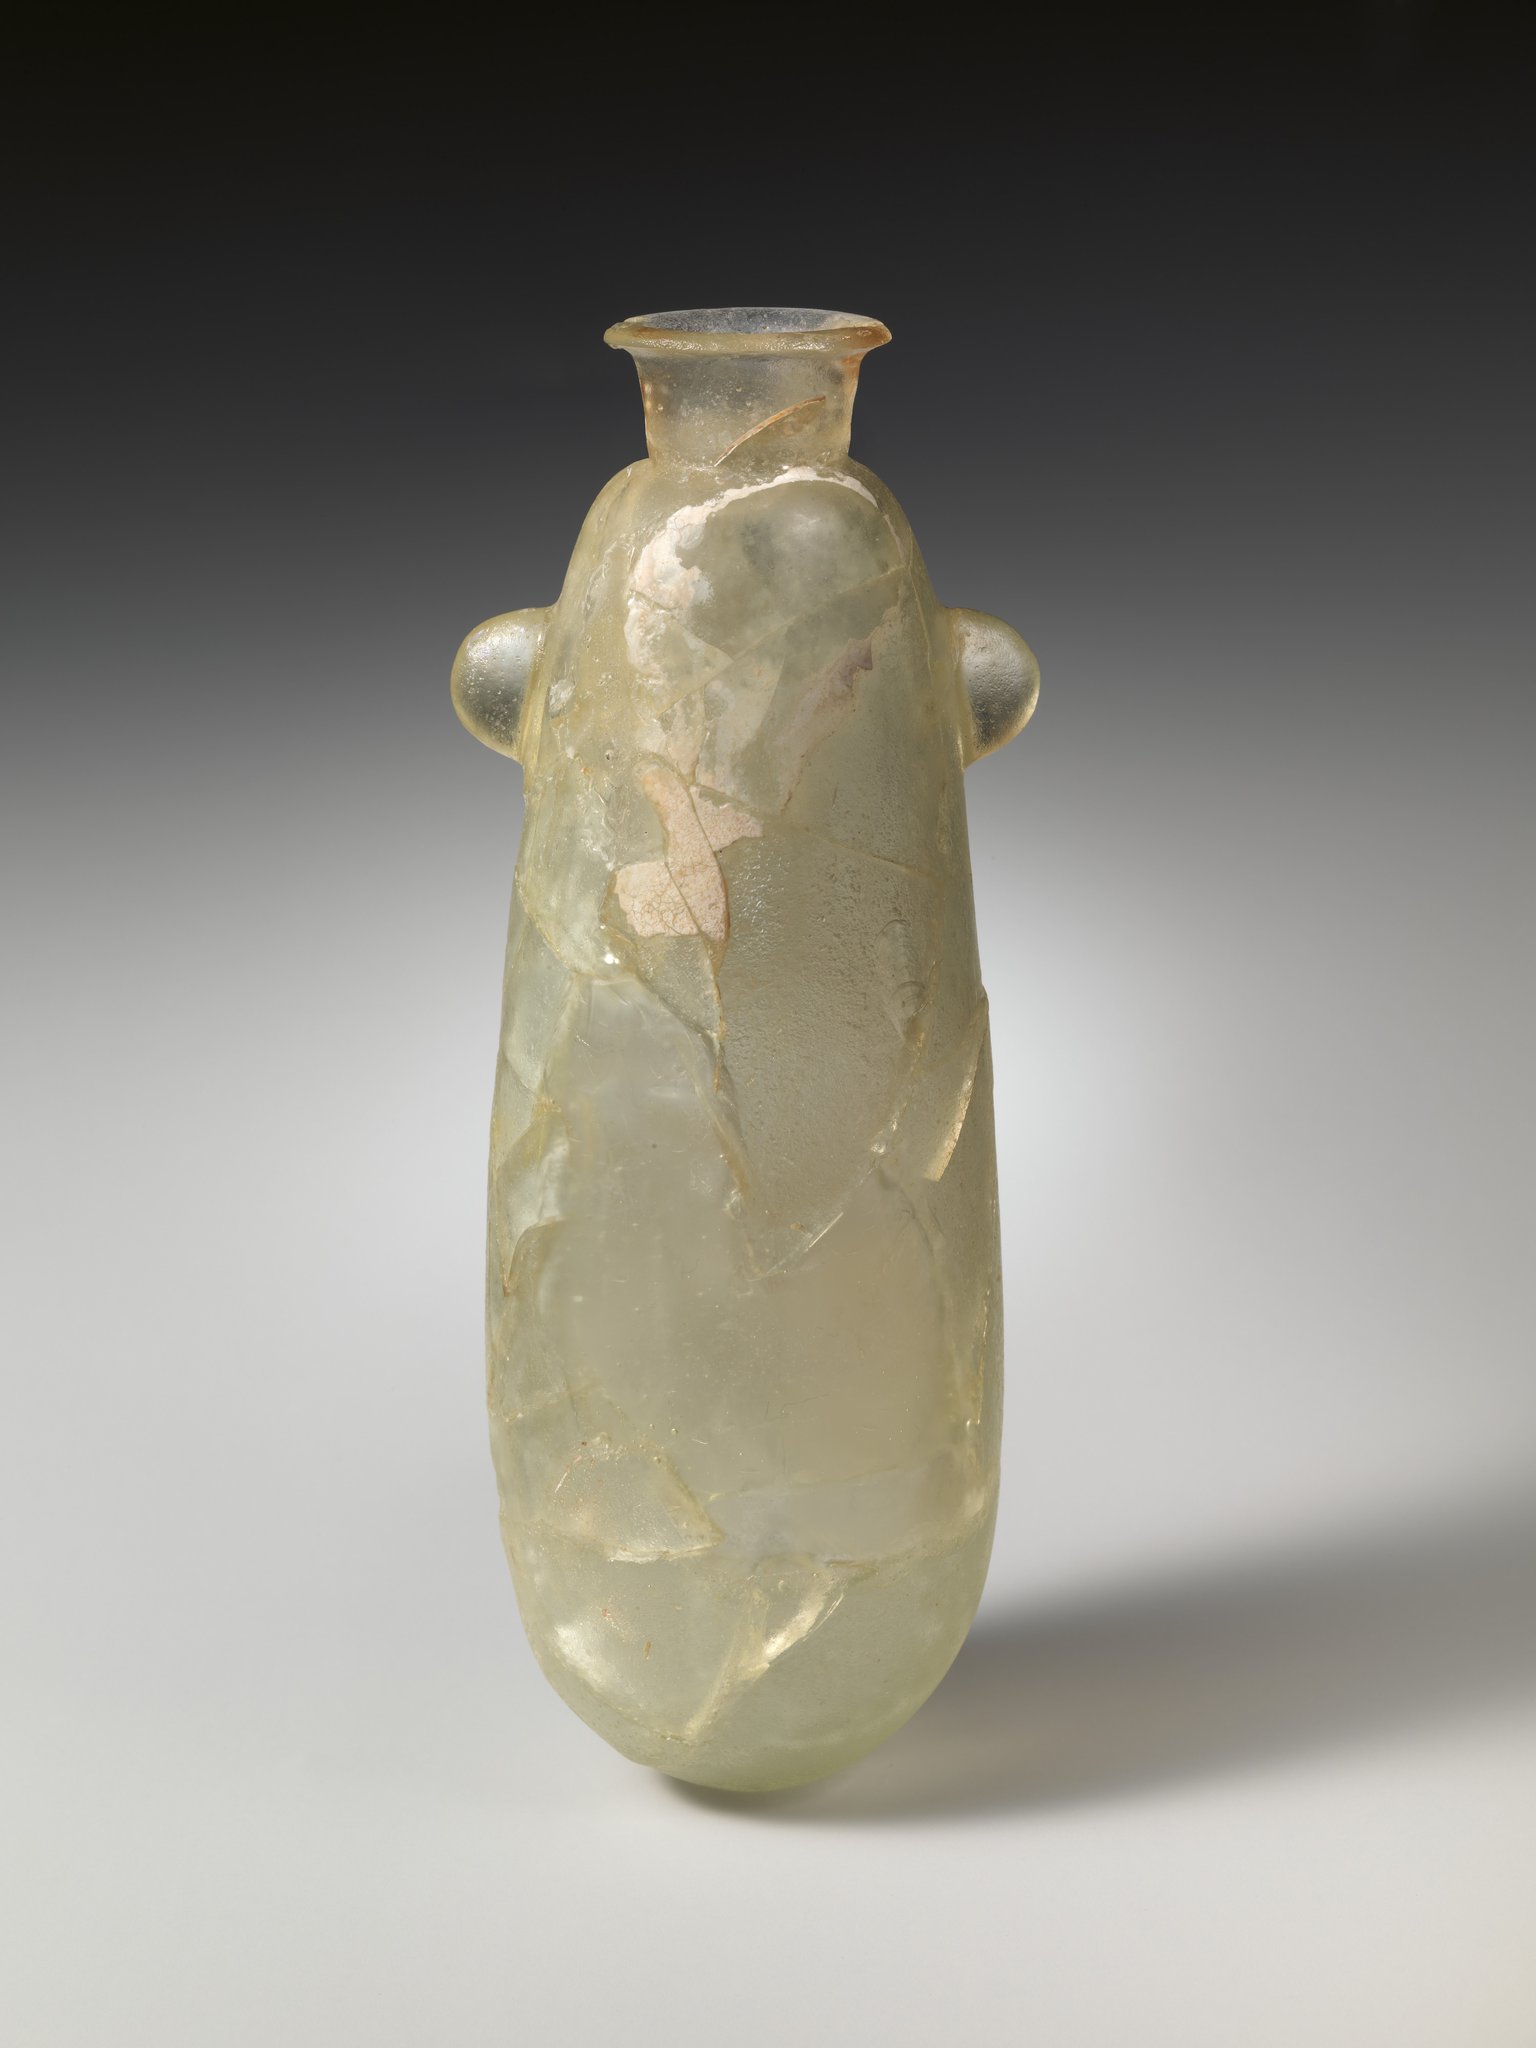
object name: alabastron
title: Glass alabastron (perfumebottle)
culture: phoenician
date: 625-600 BCE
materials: glass